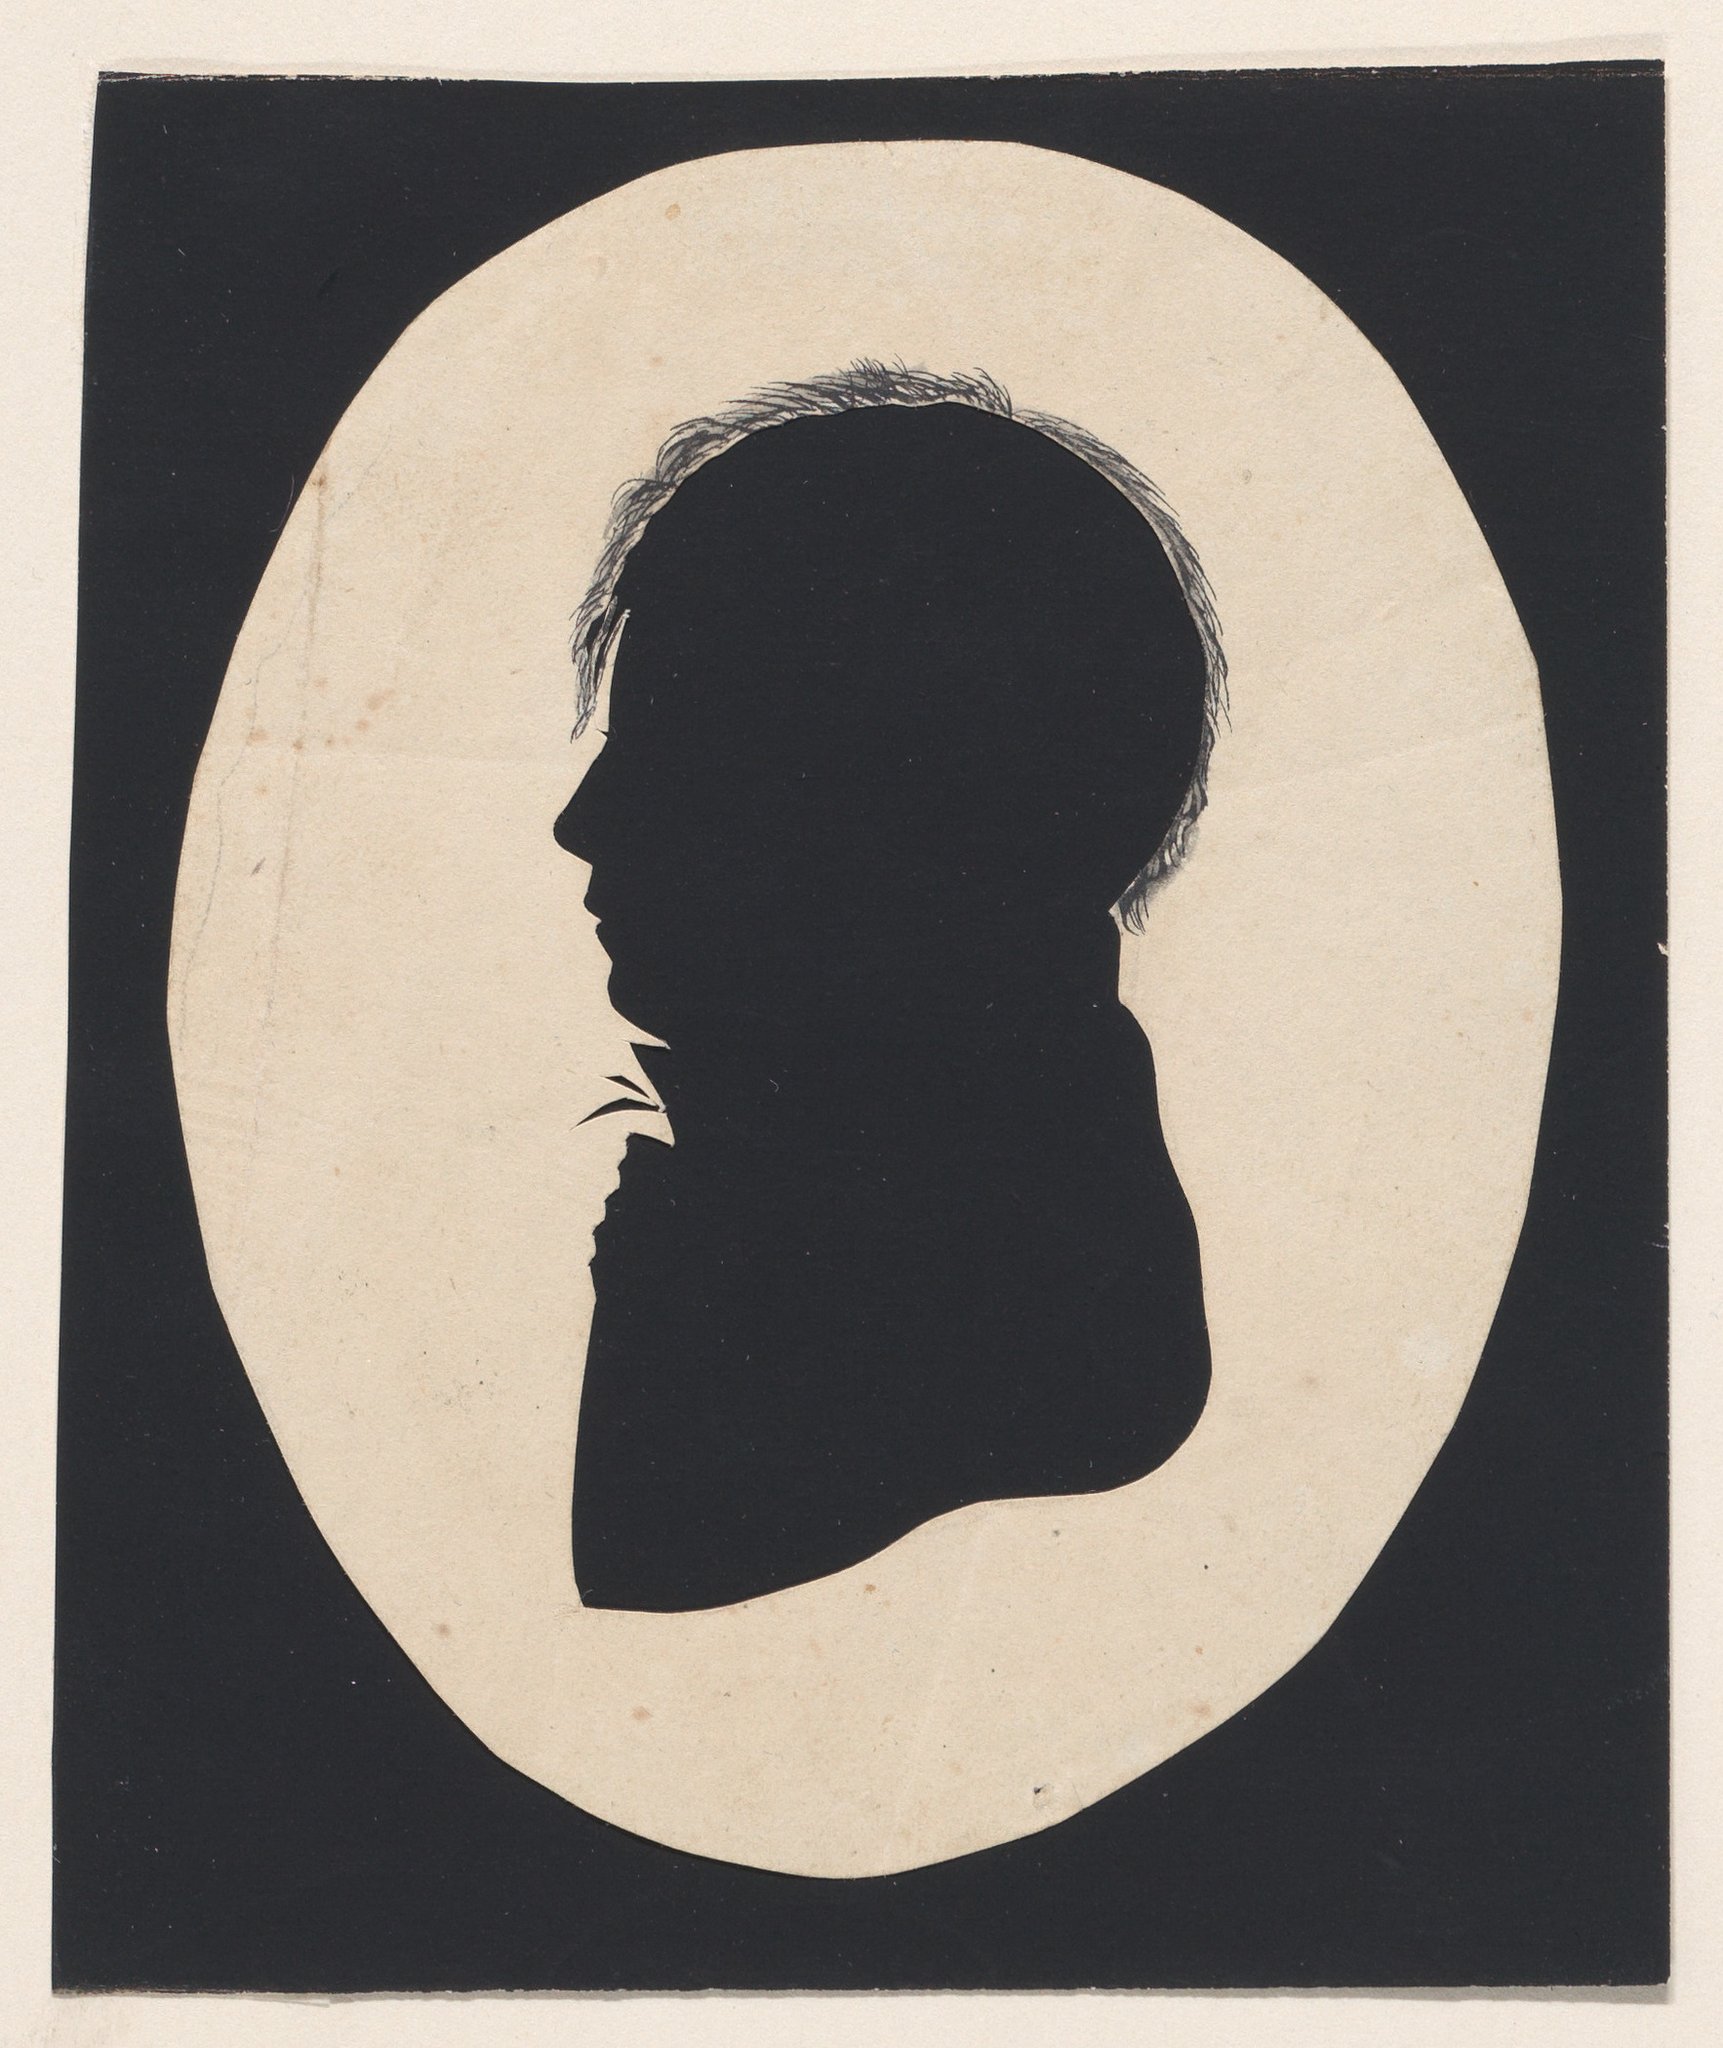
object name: cut paper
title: Silhouette of an unknown man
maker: moses chapman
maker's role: artist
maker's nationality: american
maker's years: 1783-1821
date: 1803-1821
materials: ink, paper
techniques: cutting, pen